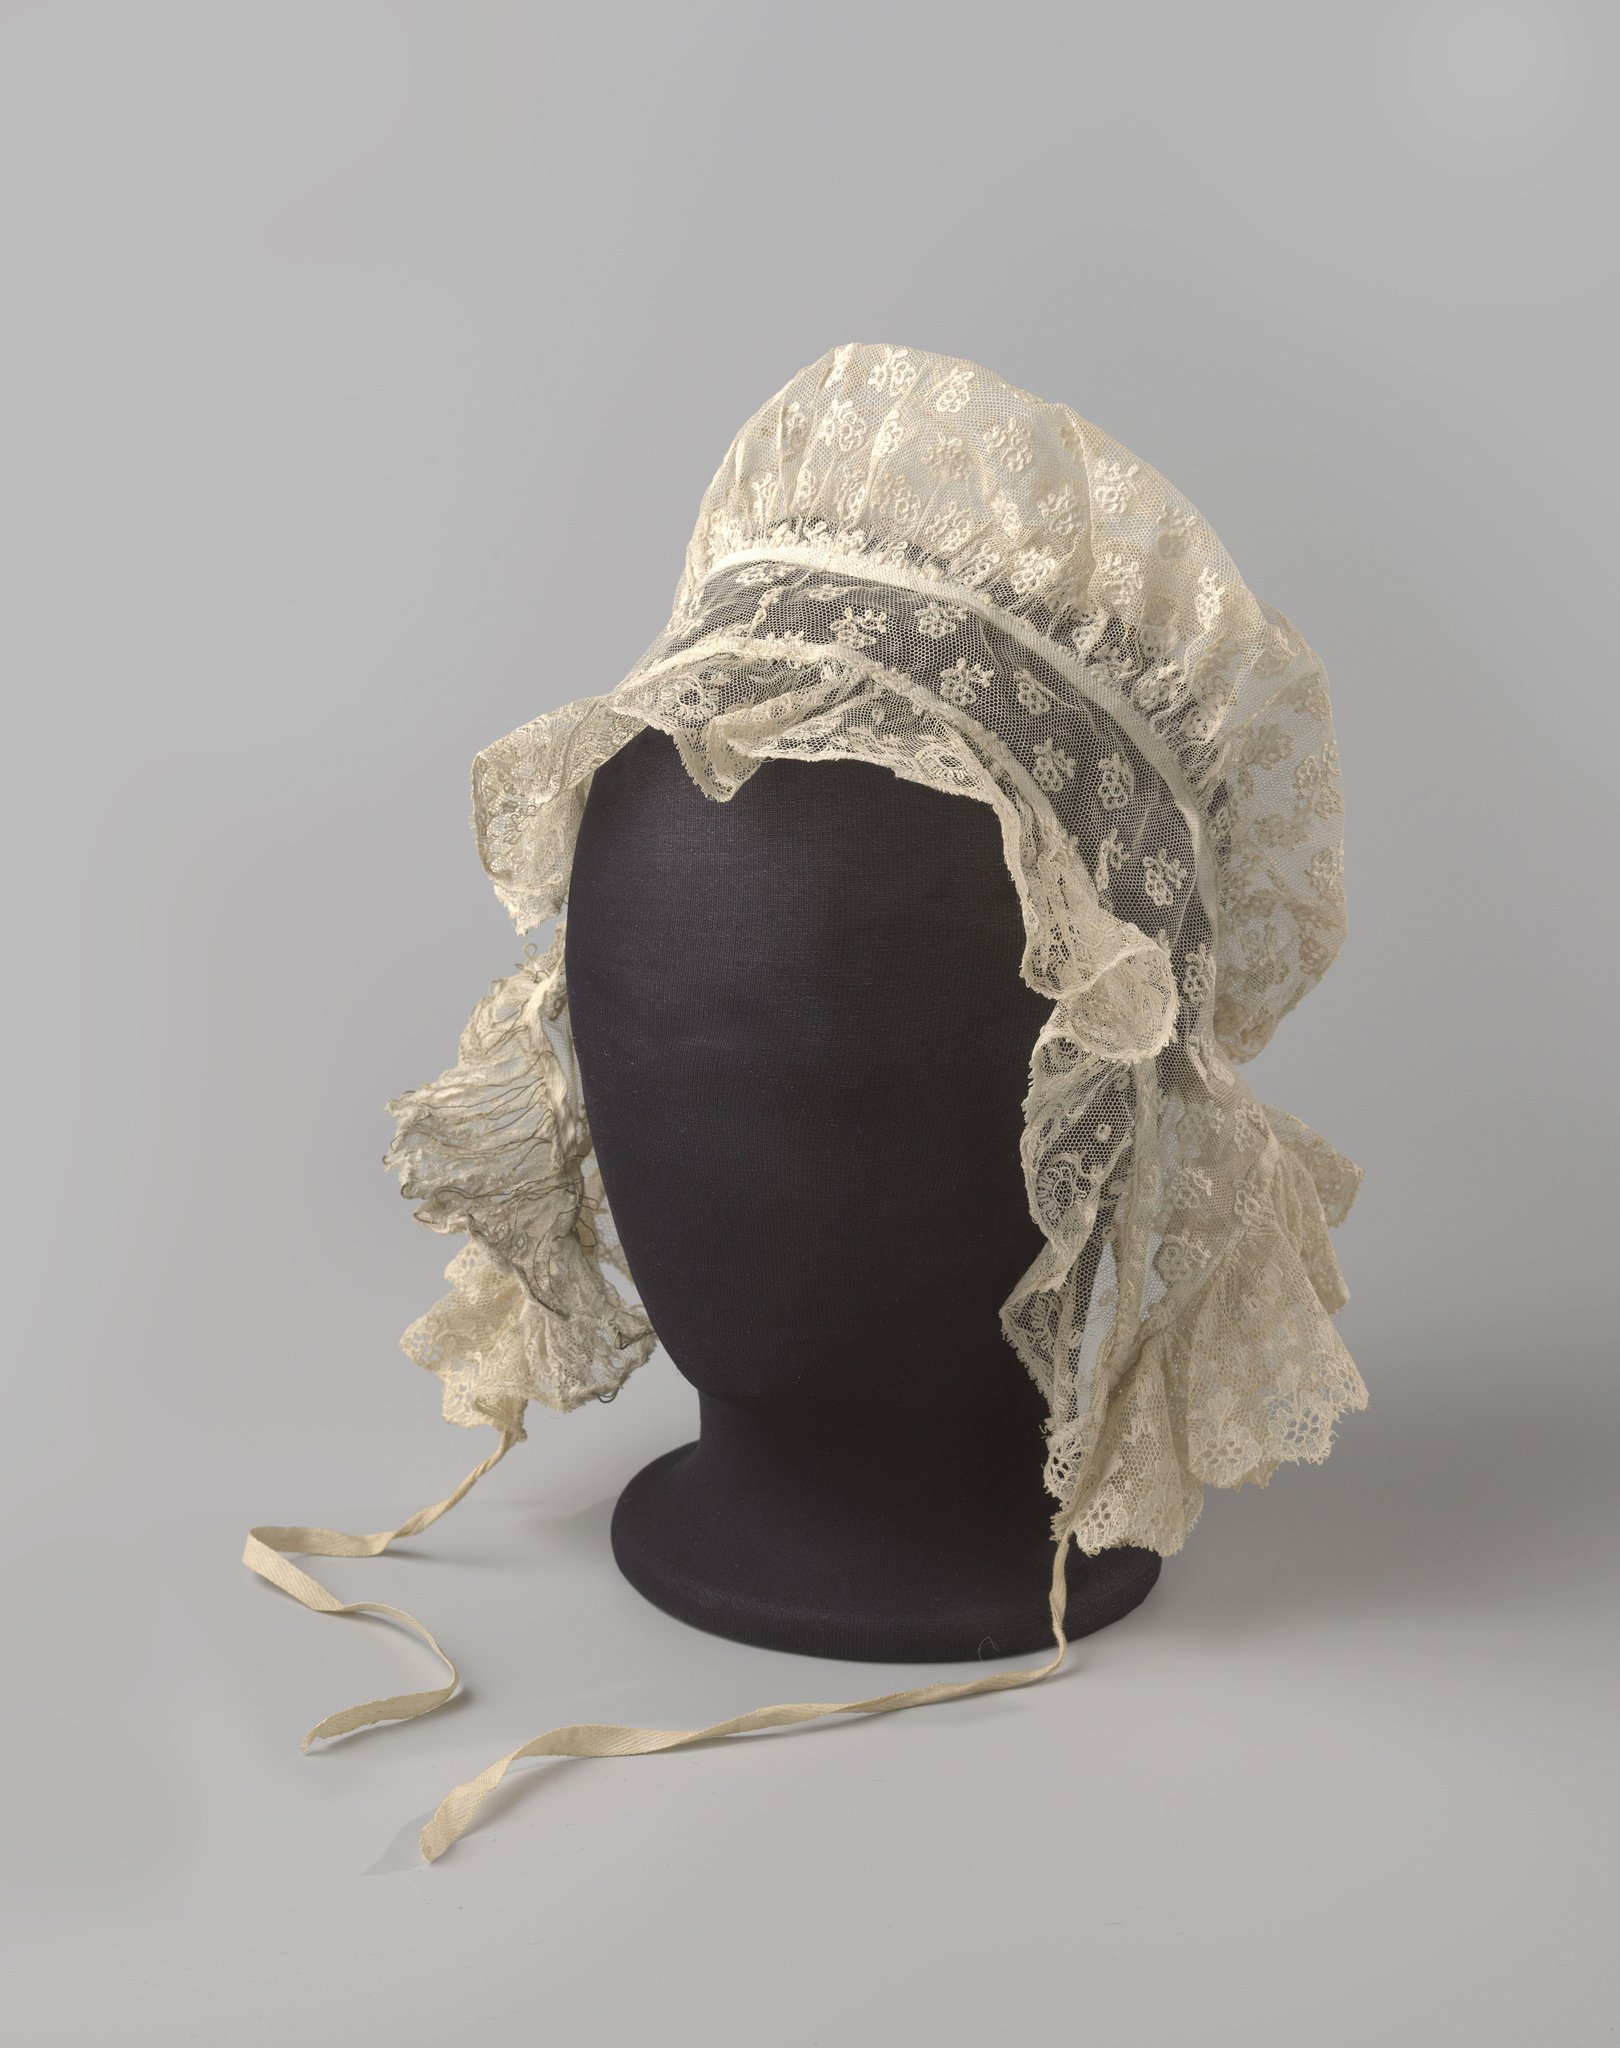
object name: cap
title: Muts van kantborduurwerk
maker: Anonymous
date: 1820-1825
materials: linen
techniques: embroidered, lace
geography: netherlands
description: Muts van naturelkleurig kantborduurwerk: Lierse kant. De mutsenbol is uit één stuk. De boogvorm heeft een rechte basis, gerimpeld aangezet aan een gladde kant, met een verbreed uiteinde. Hierlangs loopt aan de buitenzijde een gepijpte strook verstevigd met laiton. Inrijgbandje in de basis van de bol. De motieven zijn geborduurd op tule in de tamboereertechniek. Machinale Rijselse kant voor de nekstrook met een strooipatroon van kleine bloempjes aan tak.